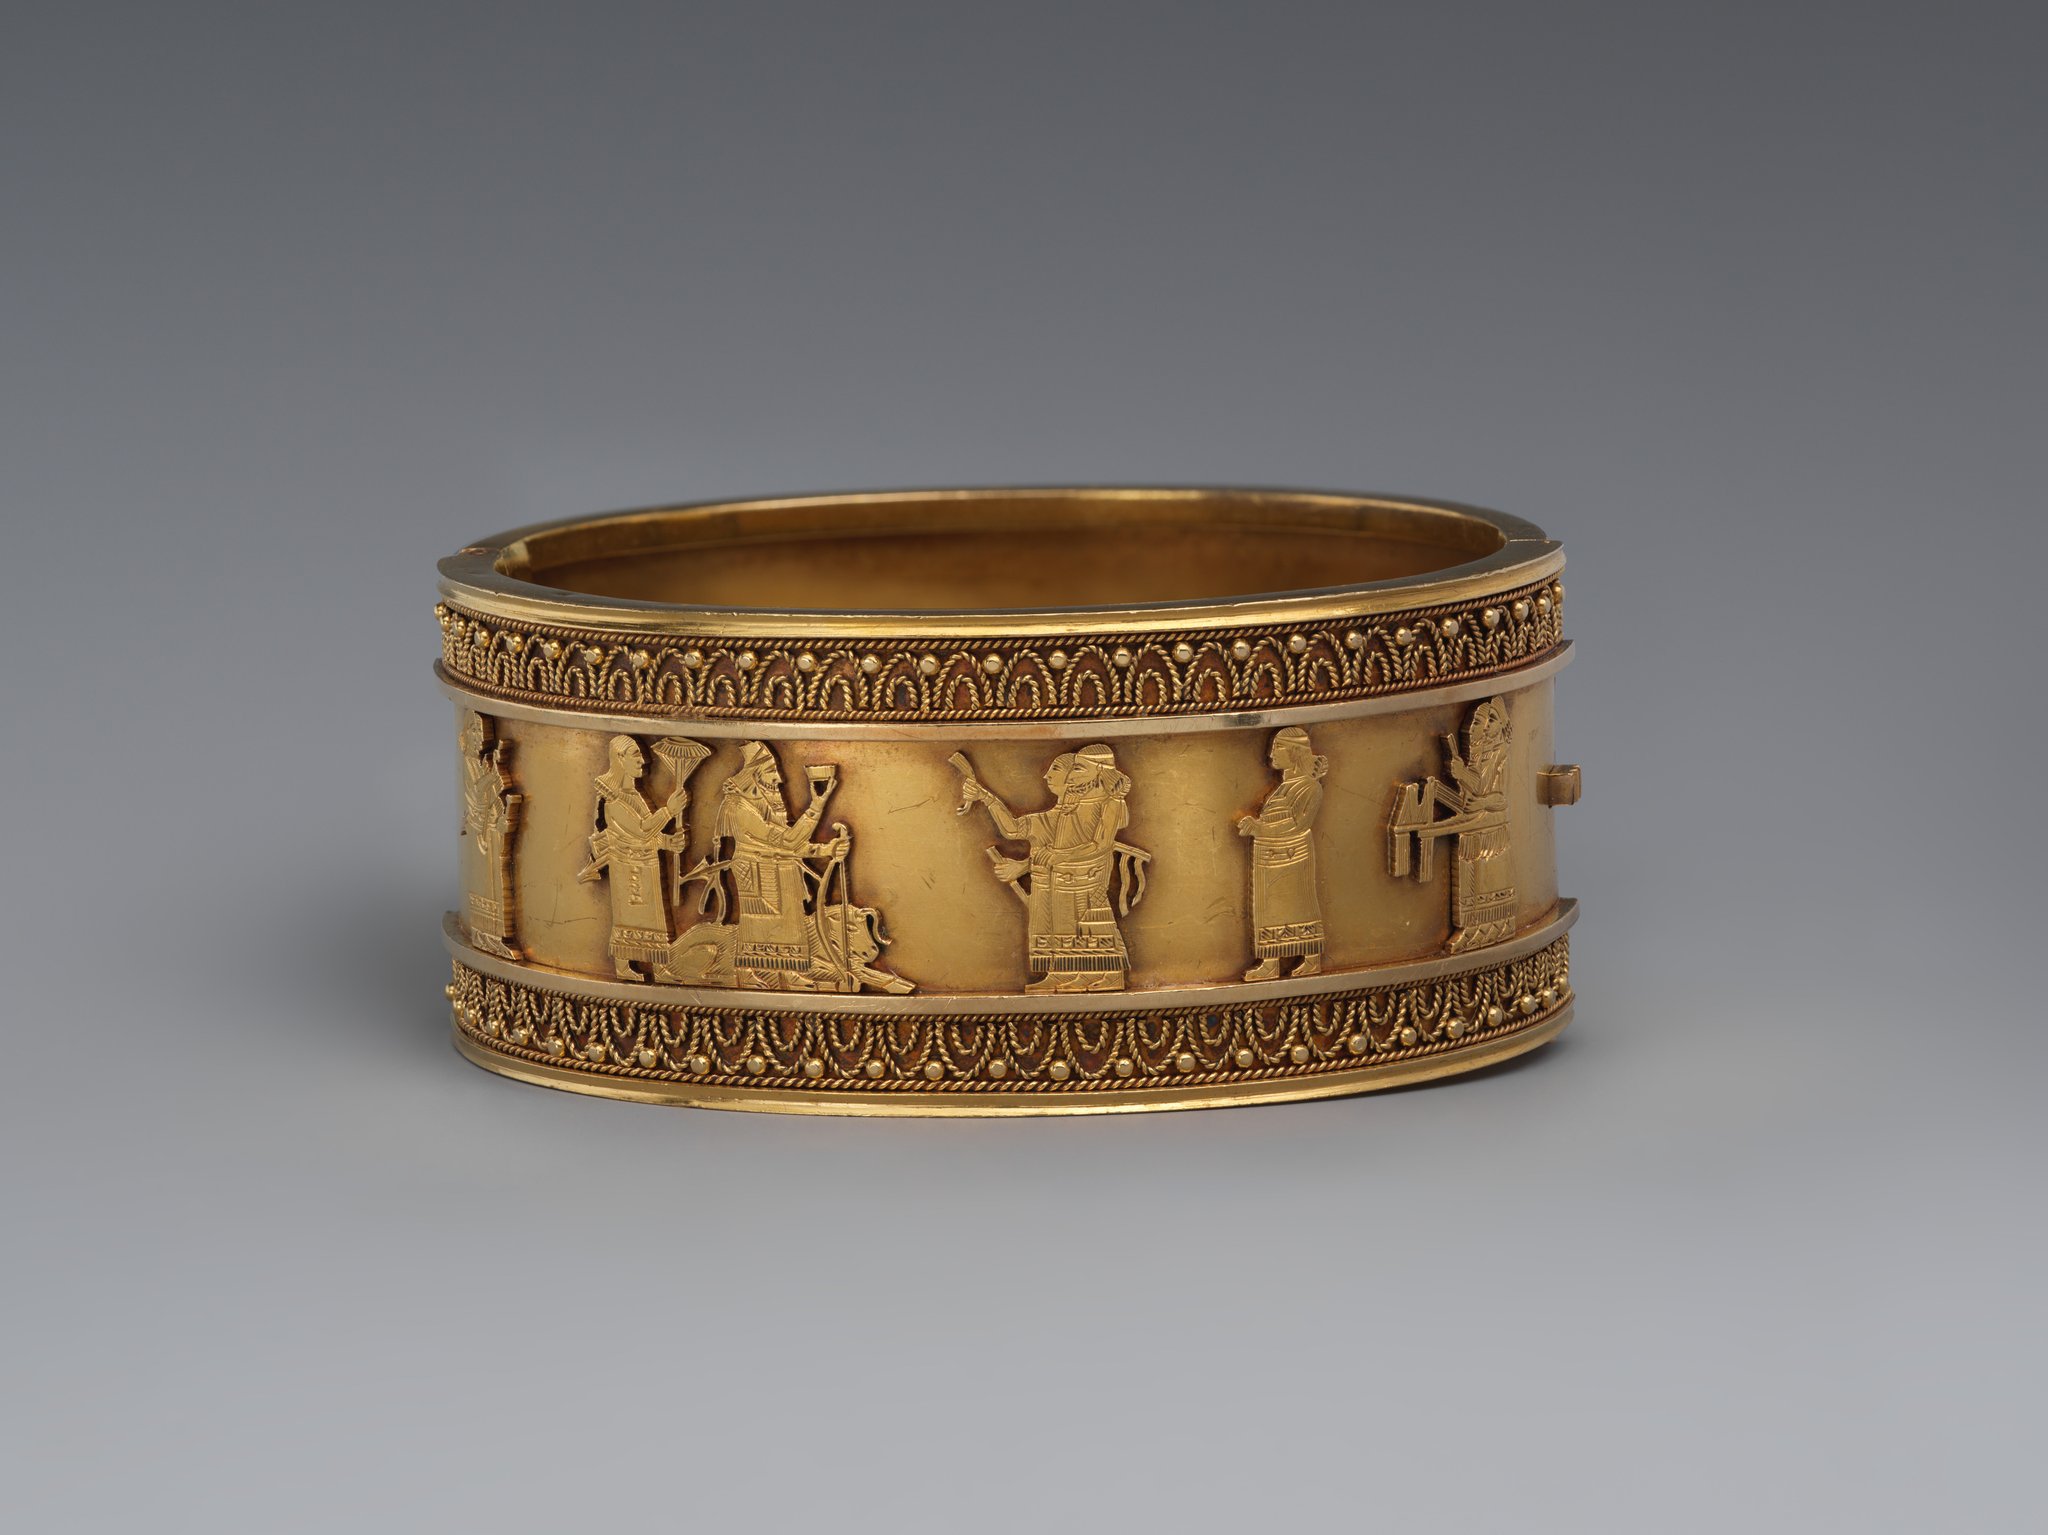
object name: bracelet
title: Bracelet with Assyrian-inspired design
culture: british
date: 1850-1880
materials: gold